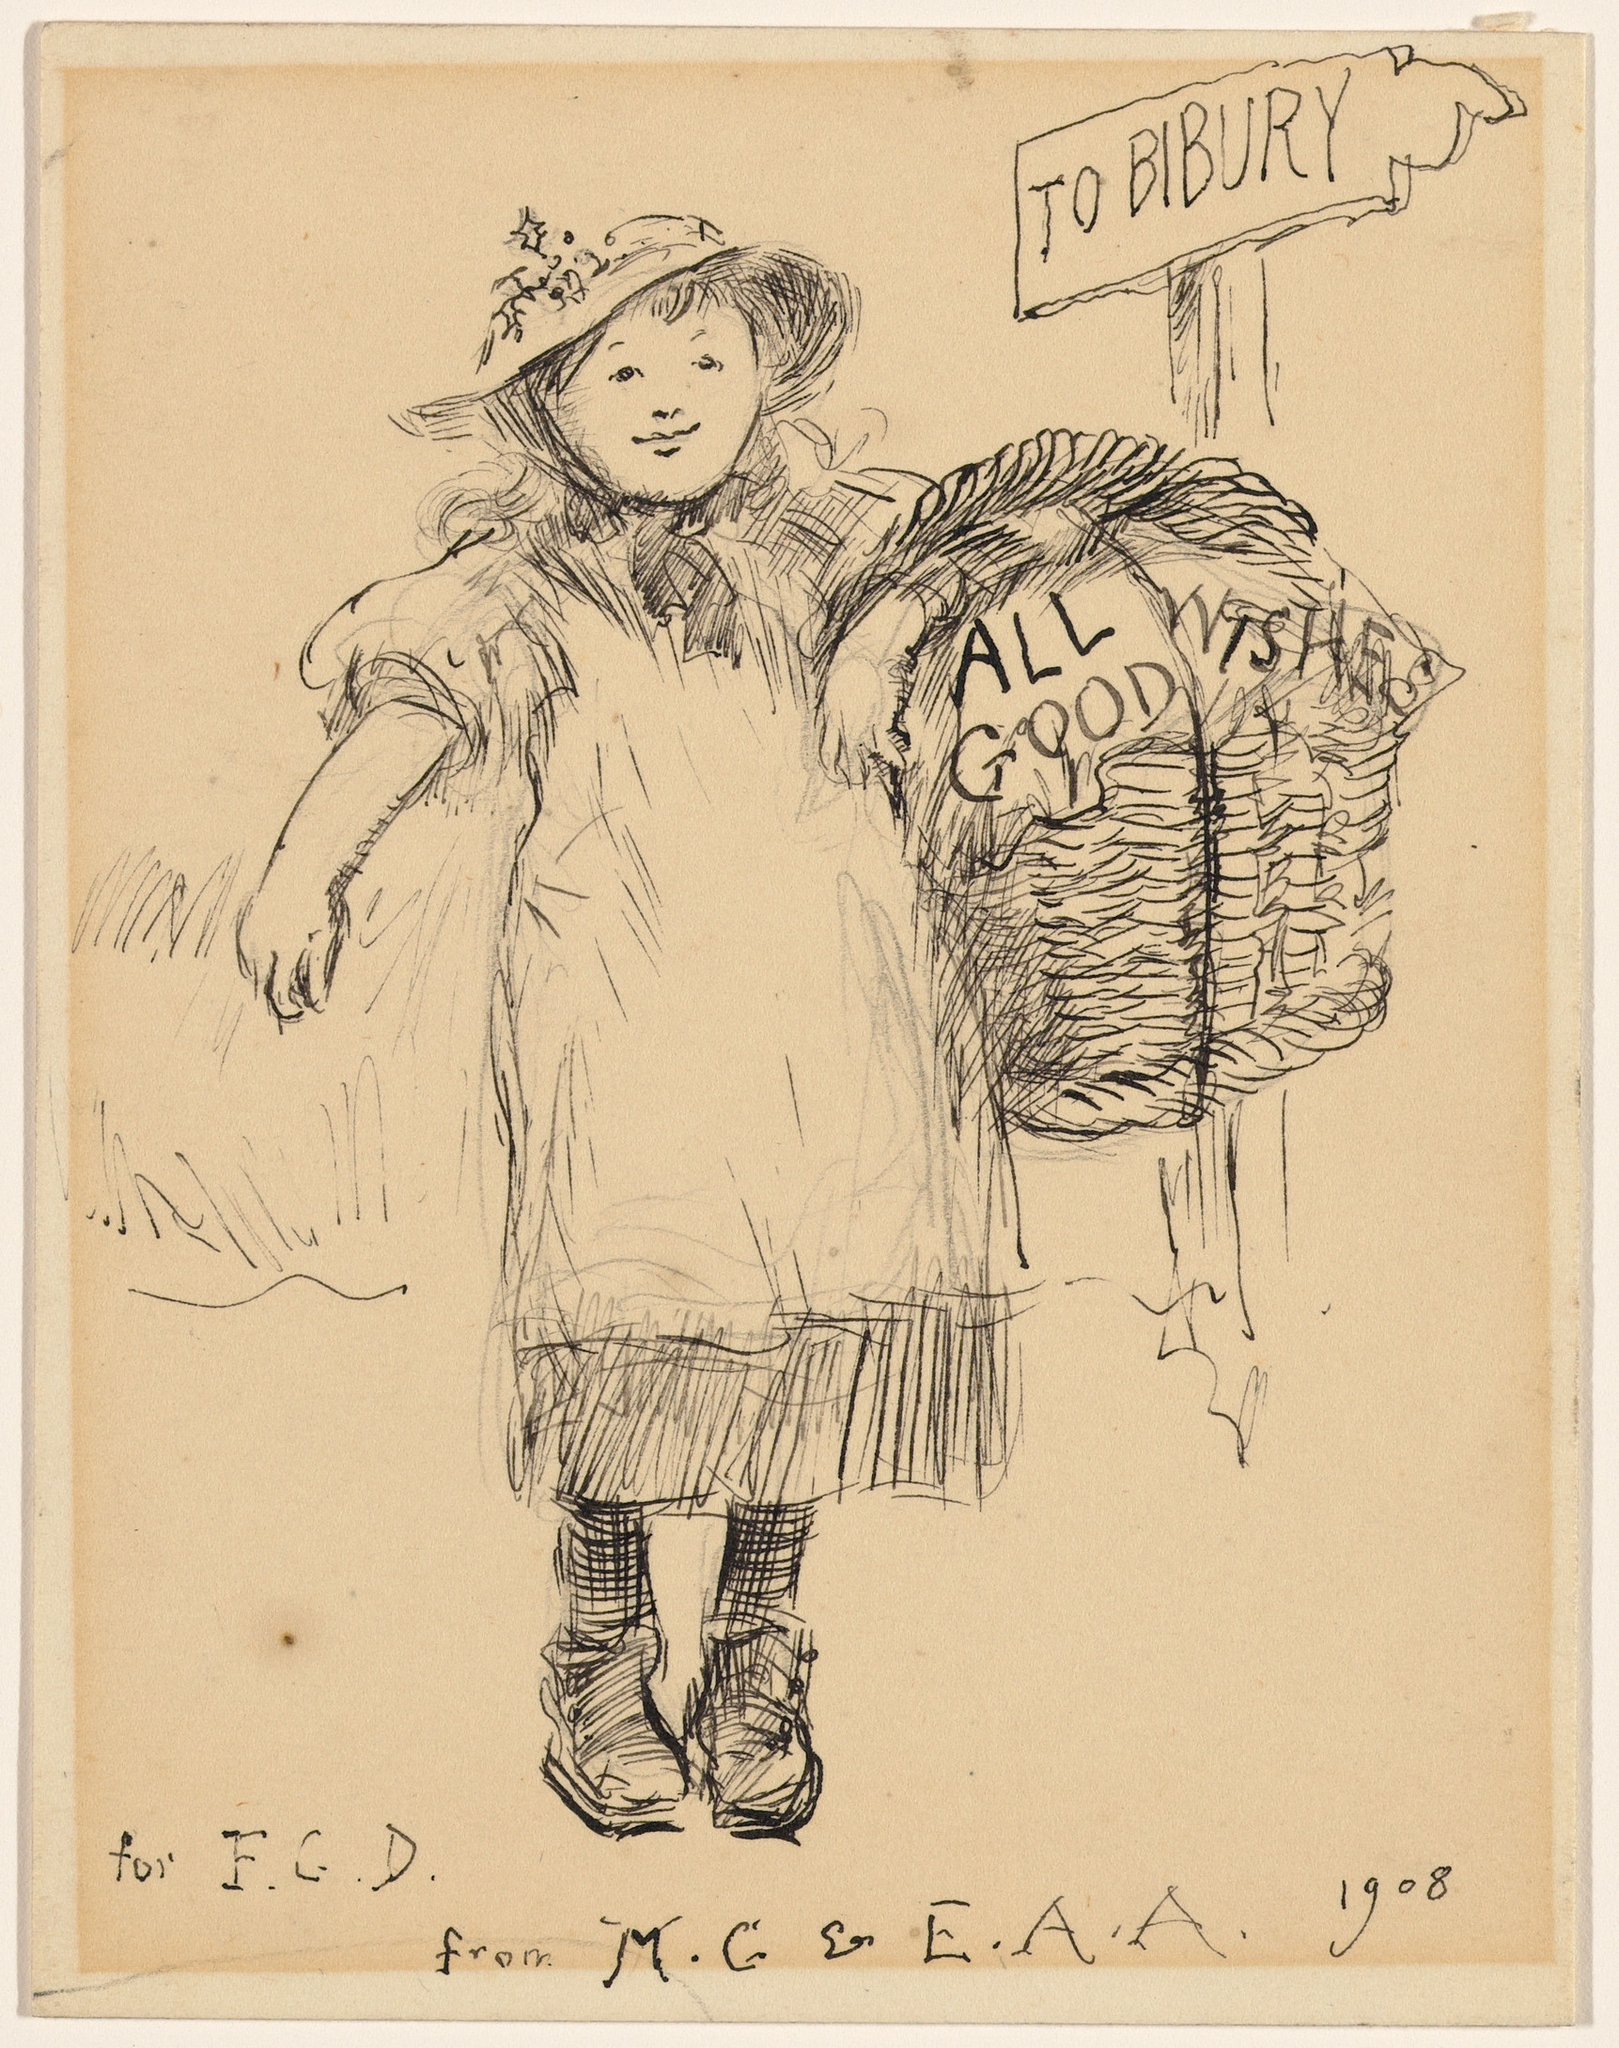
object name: drawing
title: Young Girl Carrying a Basket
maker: edwin austin abbey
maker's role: artist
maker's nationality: american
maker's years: 1852-1911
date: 1908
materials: ink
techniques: pen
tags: girls,baskets